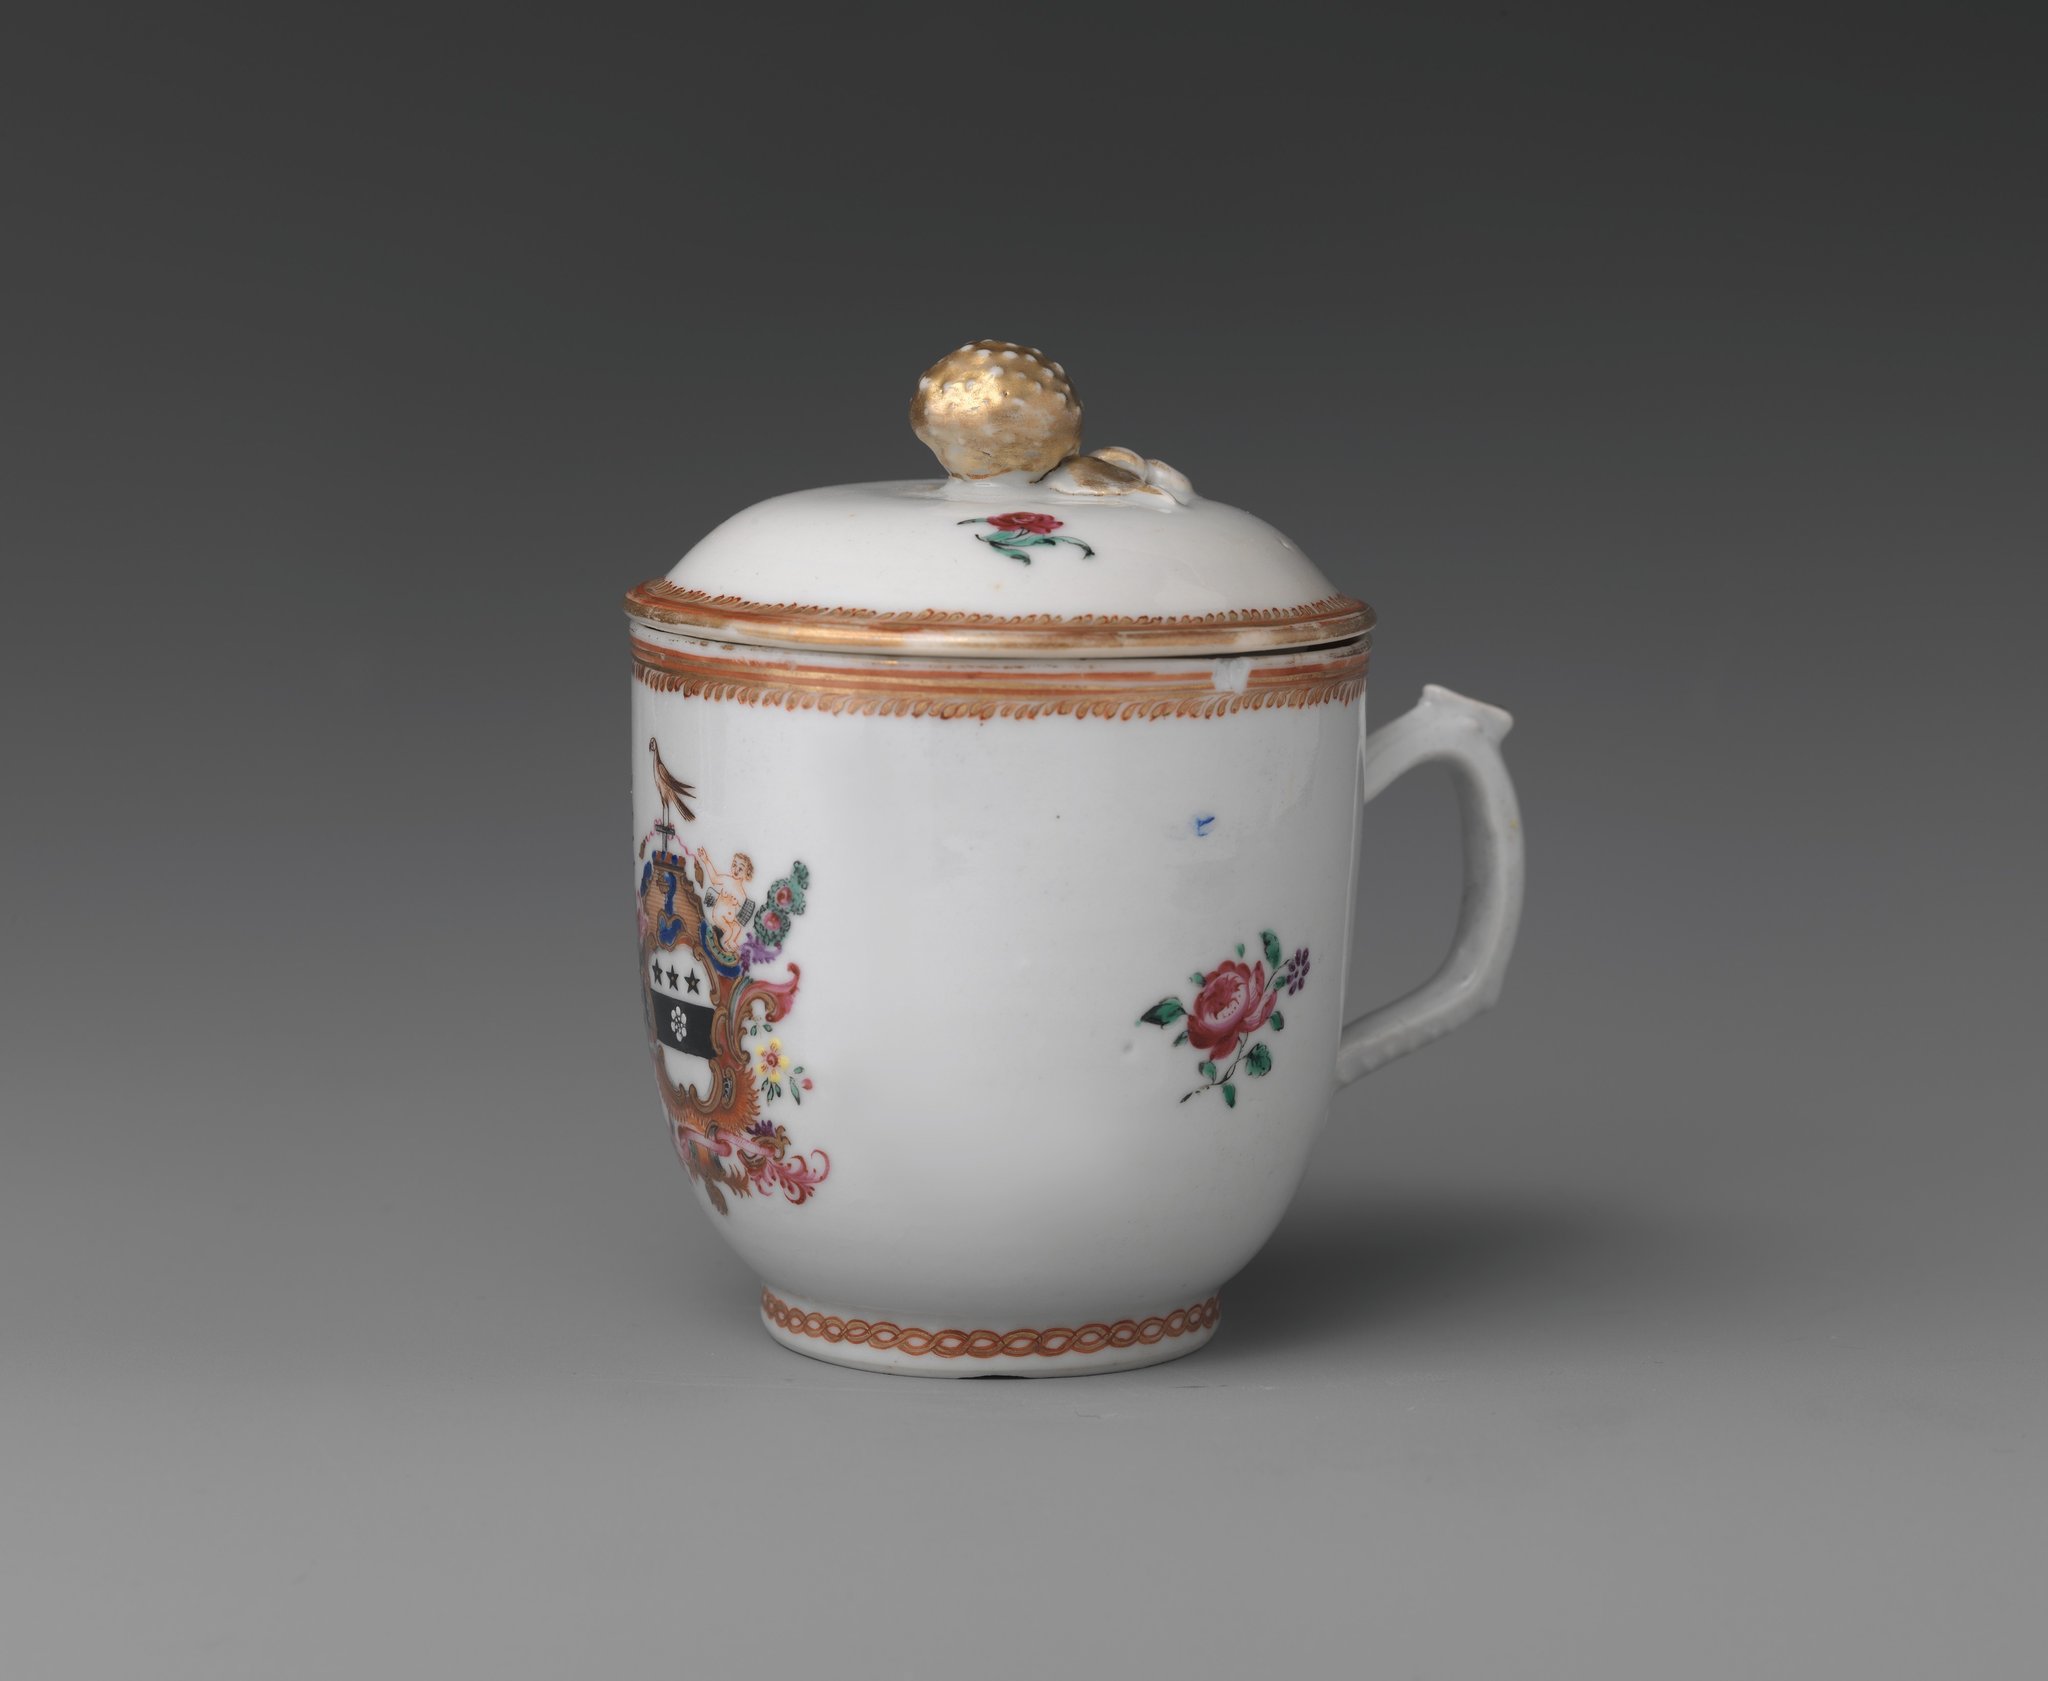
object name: cup and saucer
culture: chinese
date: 1785-1790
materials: porcelain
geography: china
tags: birds,coat of arms